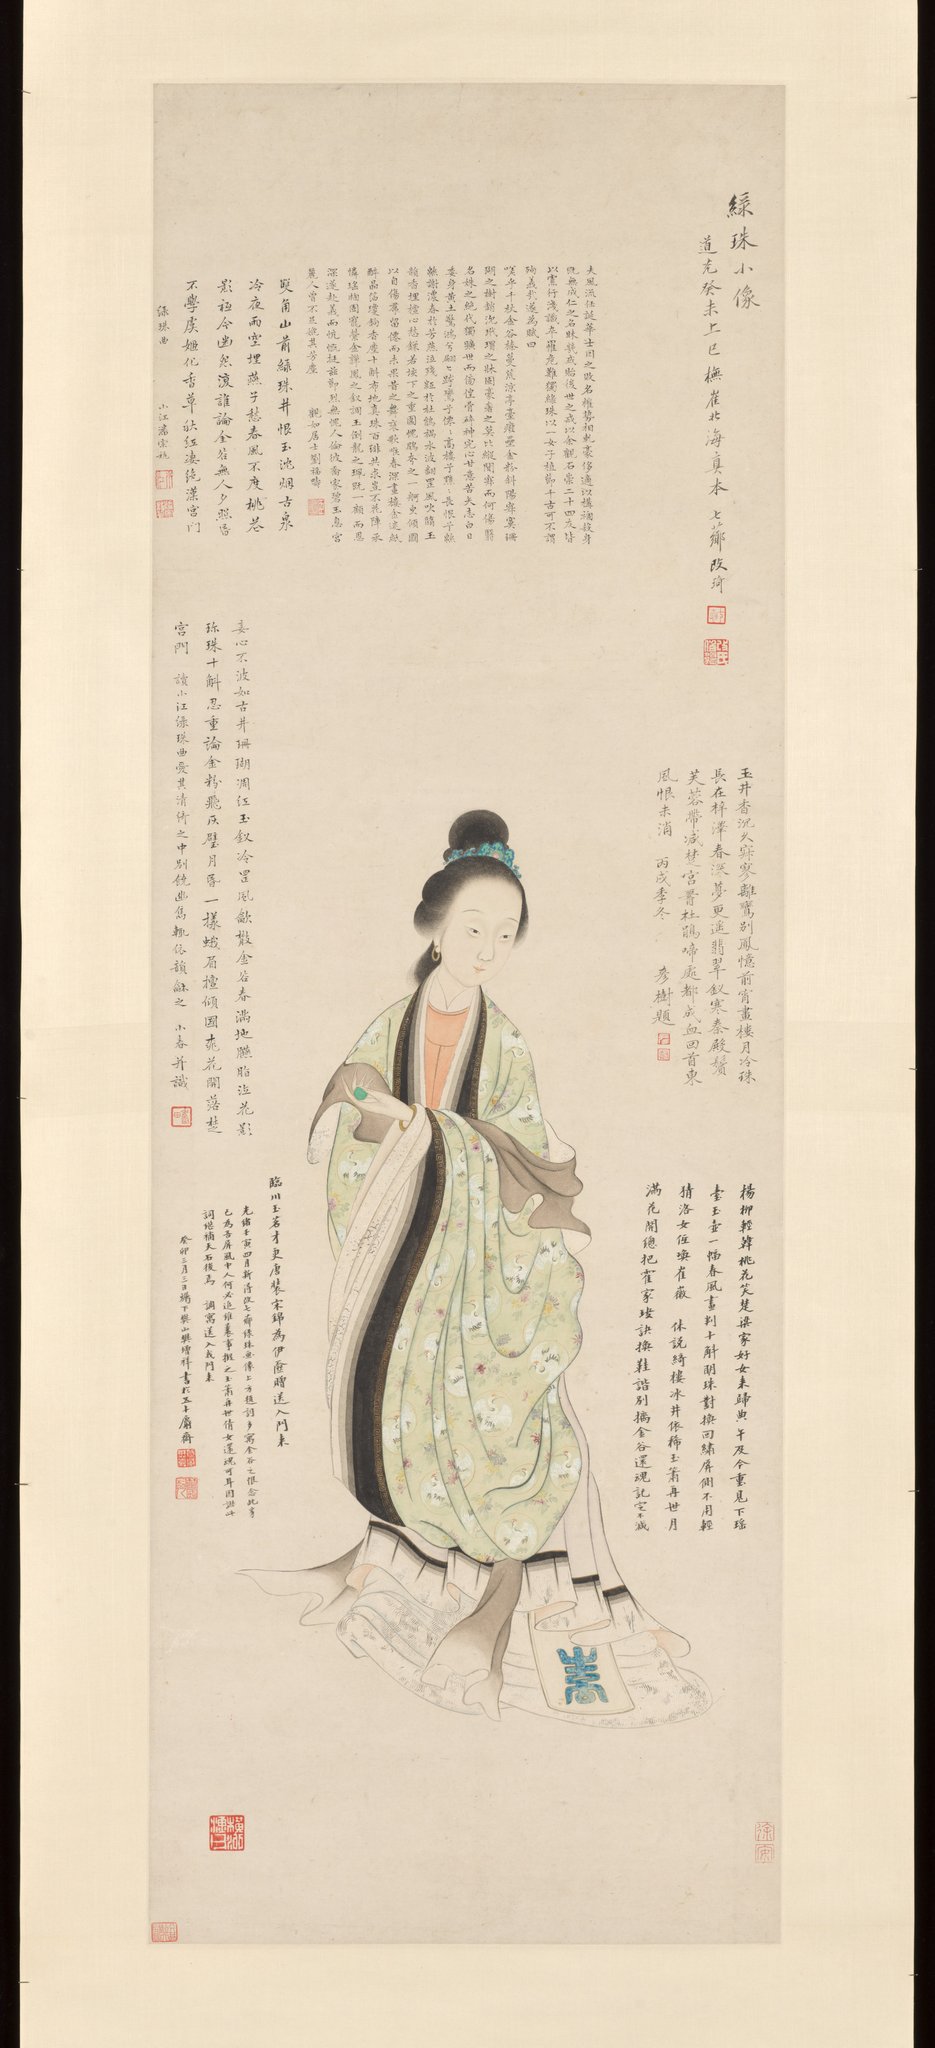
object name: hanging scroll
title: Portrait of Luzhu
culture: chinese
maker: gai qi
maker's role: artist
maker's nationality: chinese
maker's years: 1773-1828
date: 1823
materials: ink, paper